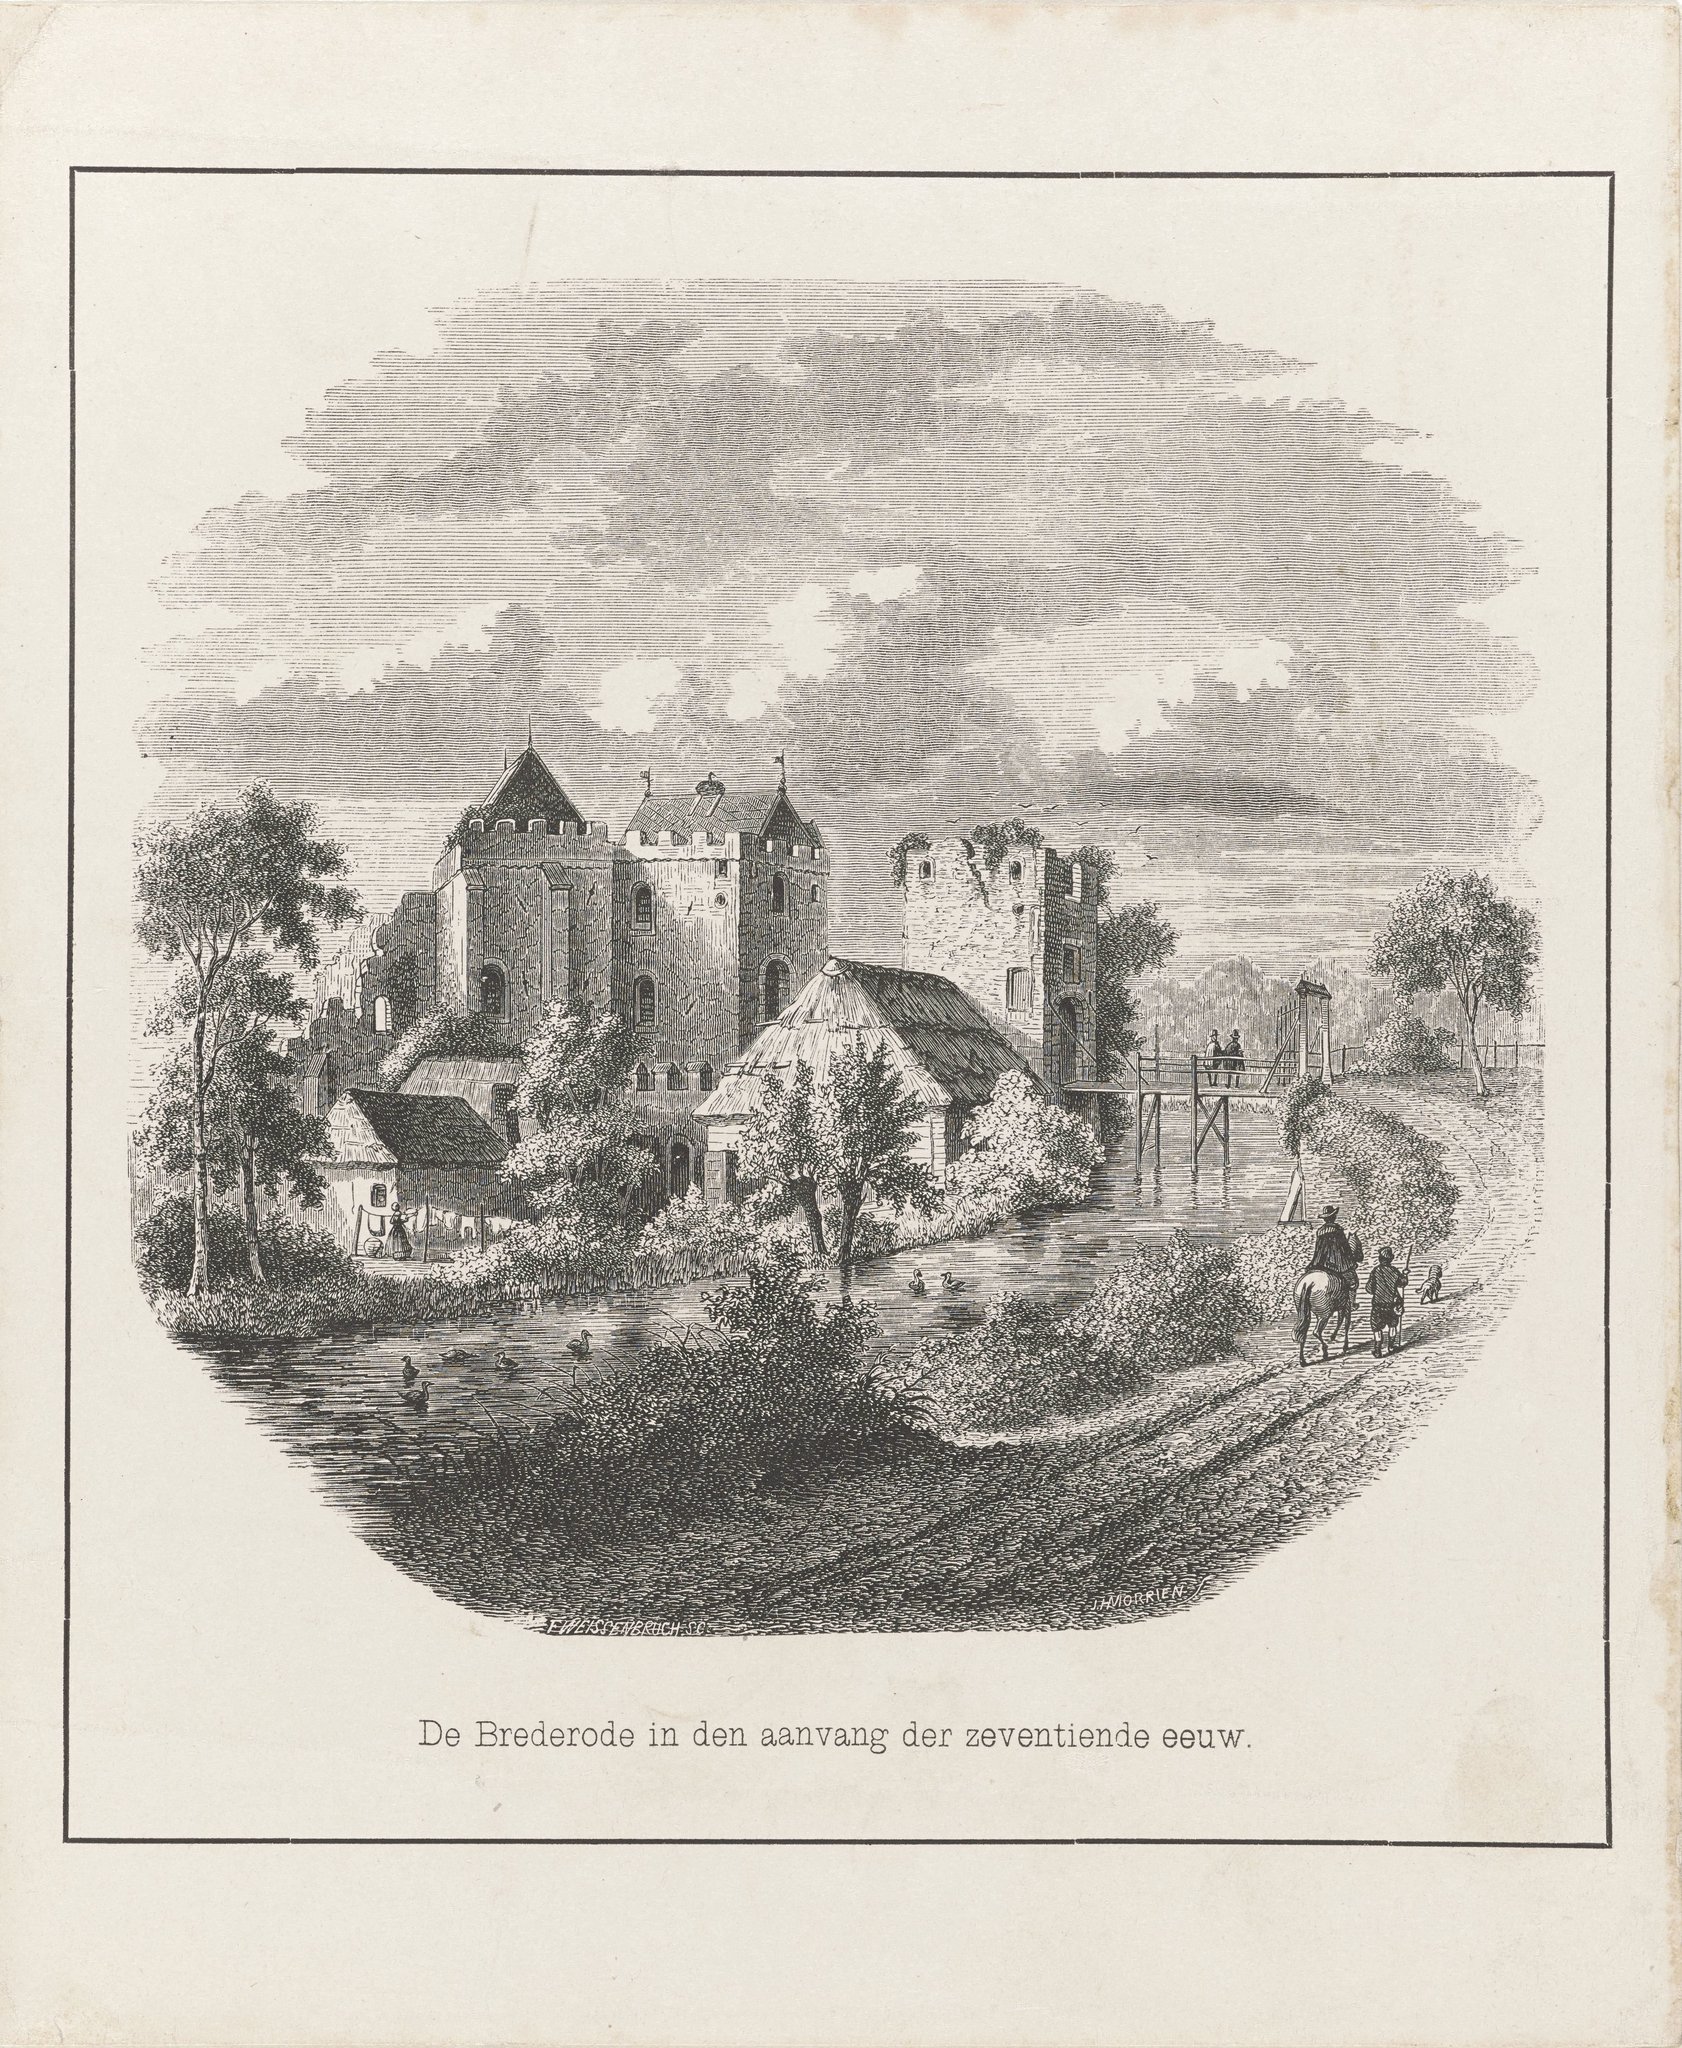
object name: print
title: De Brederode in den aanvang der zeventiende eeuw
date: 1838-1887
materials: paper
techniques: engraving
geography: the hague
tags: ruïne van kasteel brederode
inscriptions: collector's mark: Lugt 2228